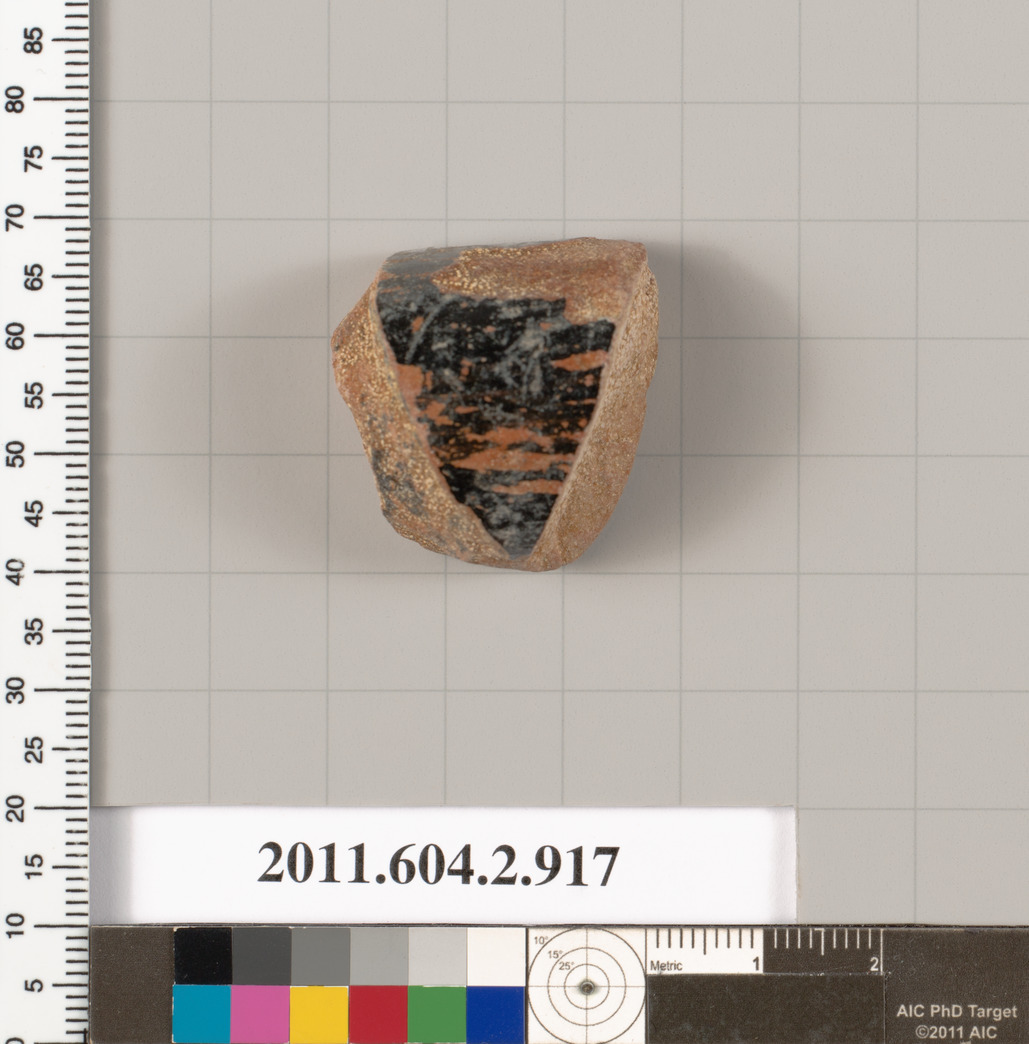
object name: bell krater fragment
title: Terracotta fragment of a bell-krater (bowl for mixing wine and water)?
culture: greek, attic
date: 450-401 BCE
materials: terracotta